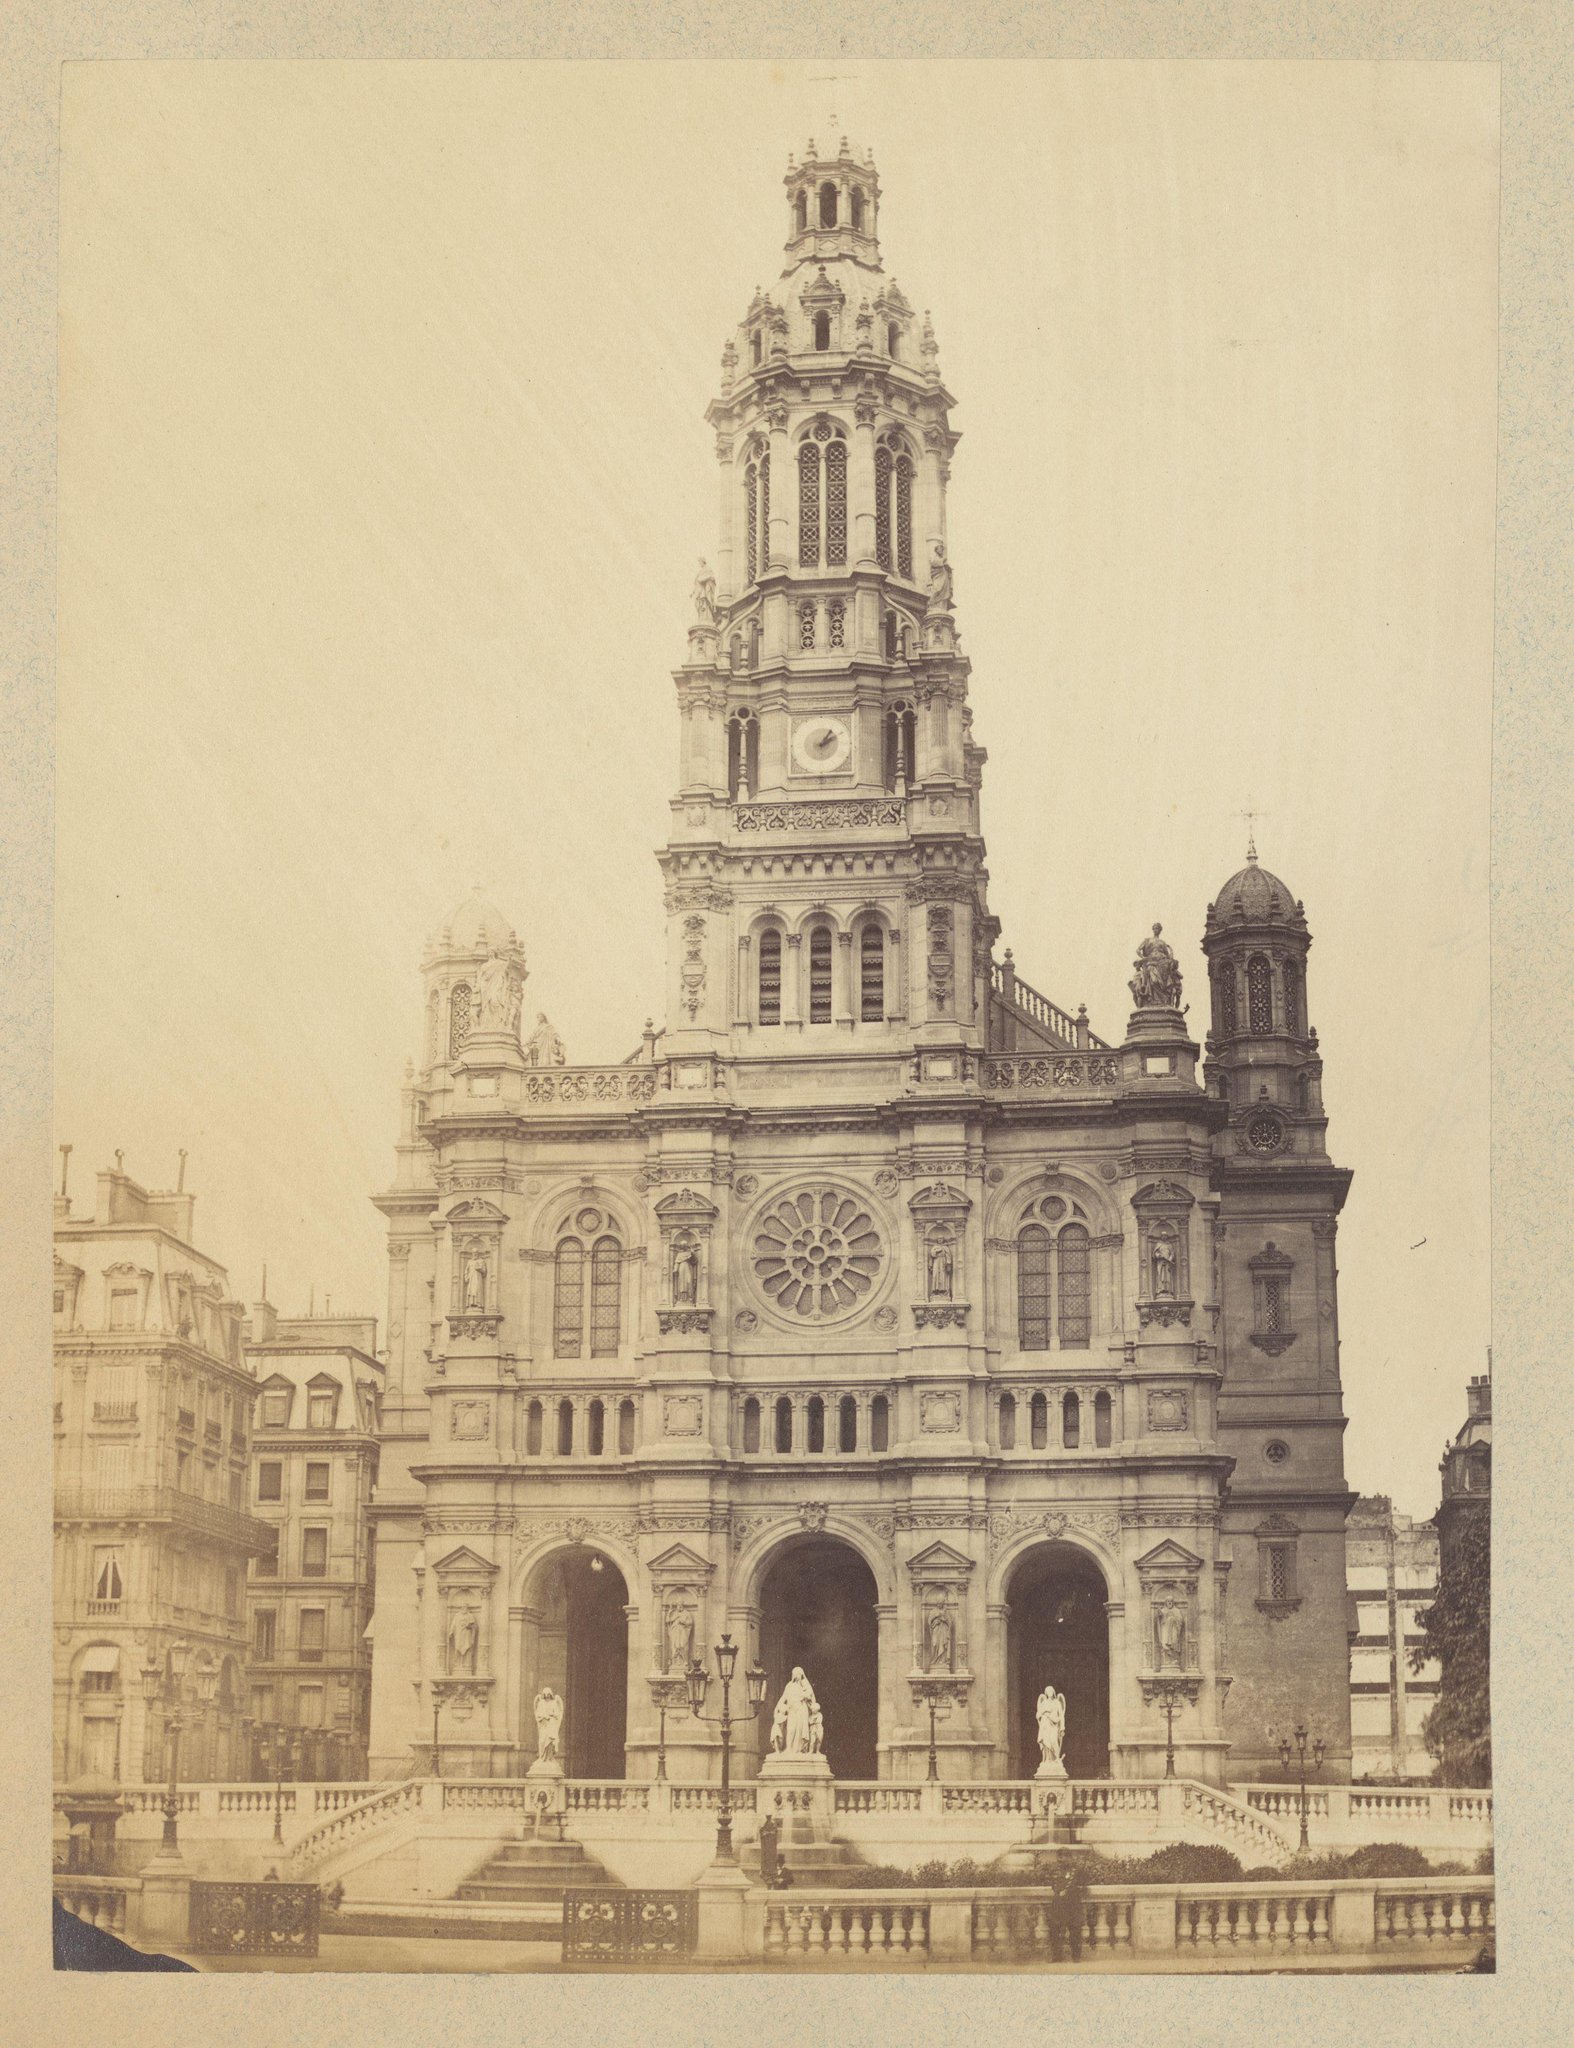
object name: photograph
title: Gezicht op de Église de la Sainte-Trinité te Parijs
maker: Anonymous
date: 1867-1900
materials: cardboard, photographic support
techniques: albumen print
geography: paris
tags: church (exterior)